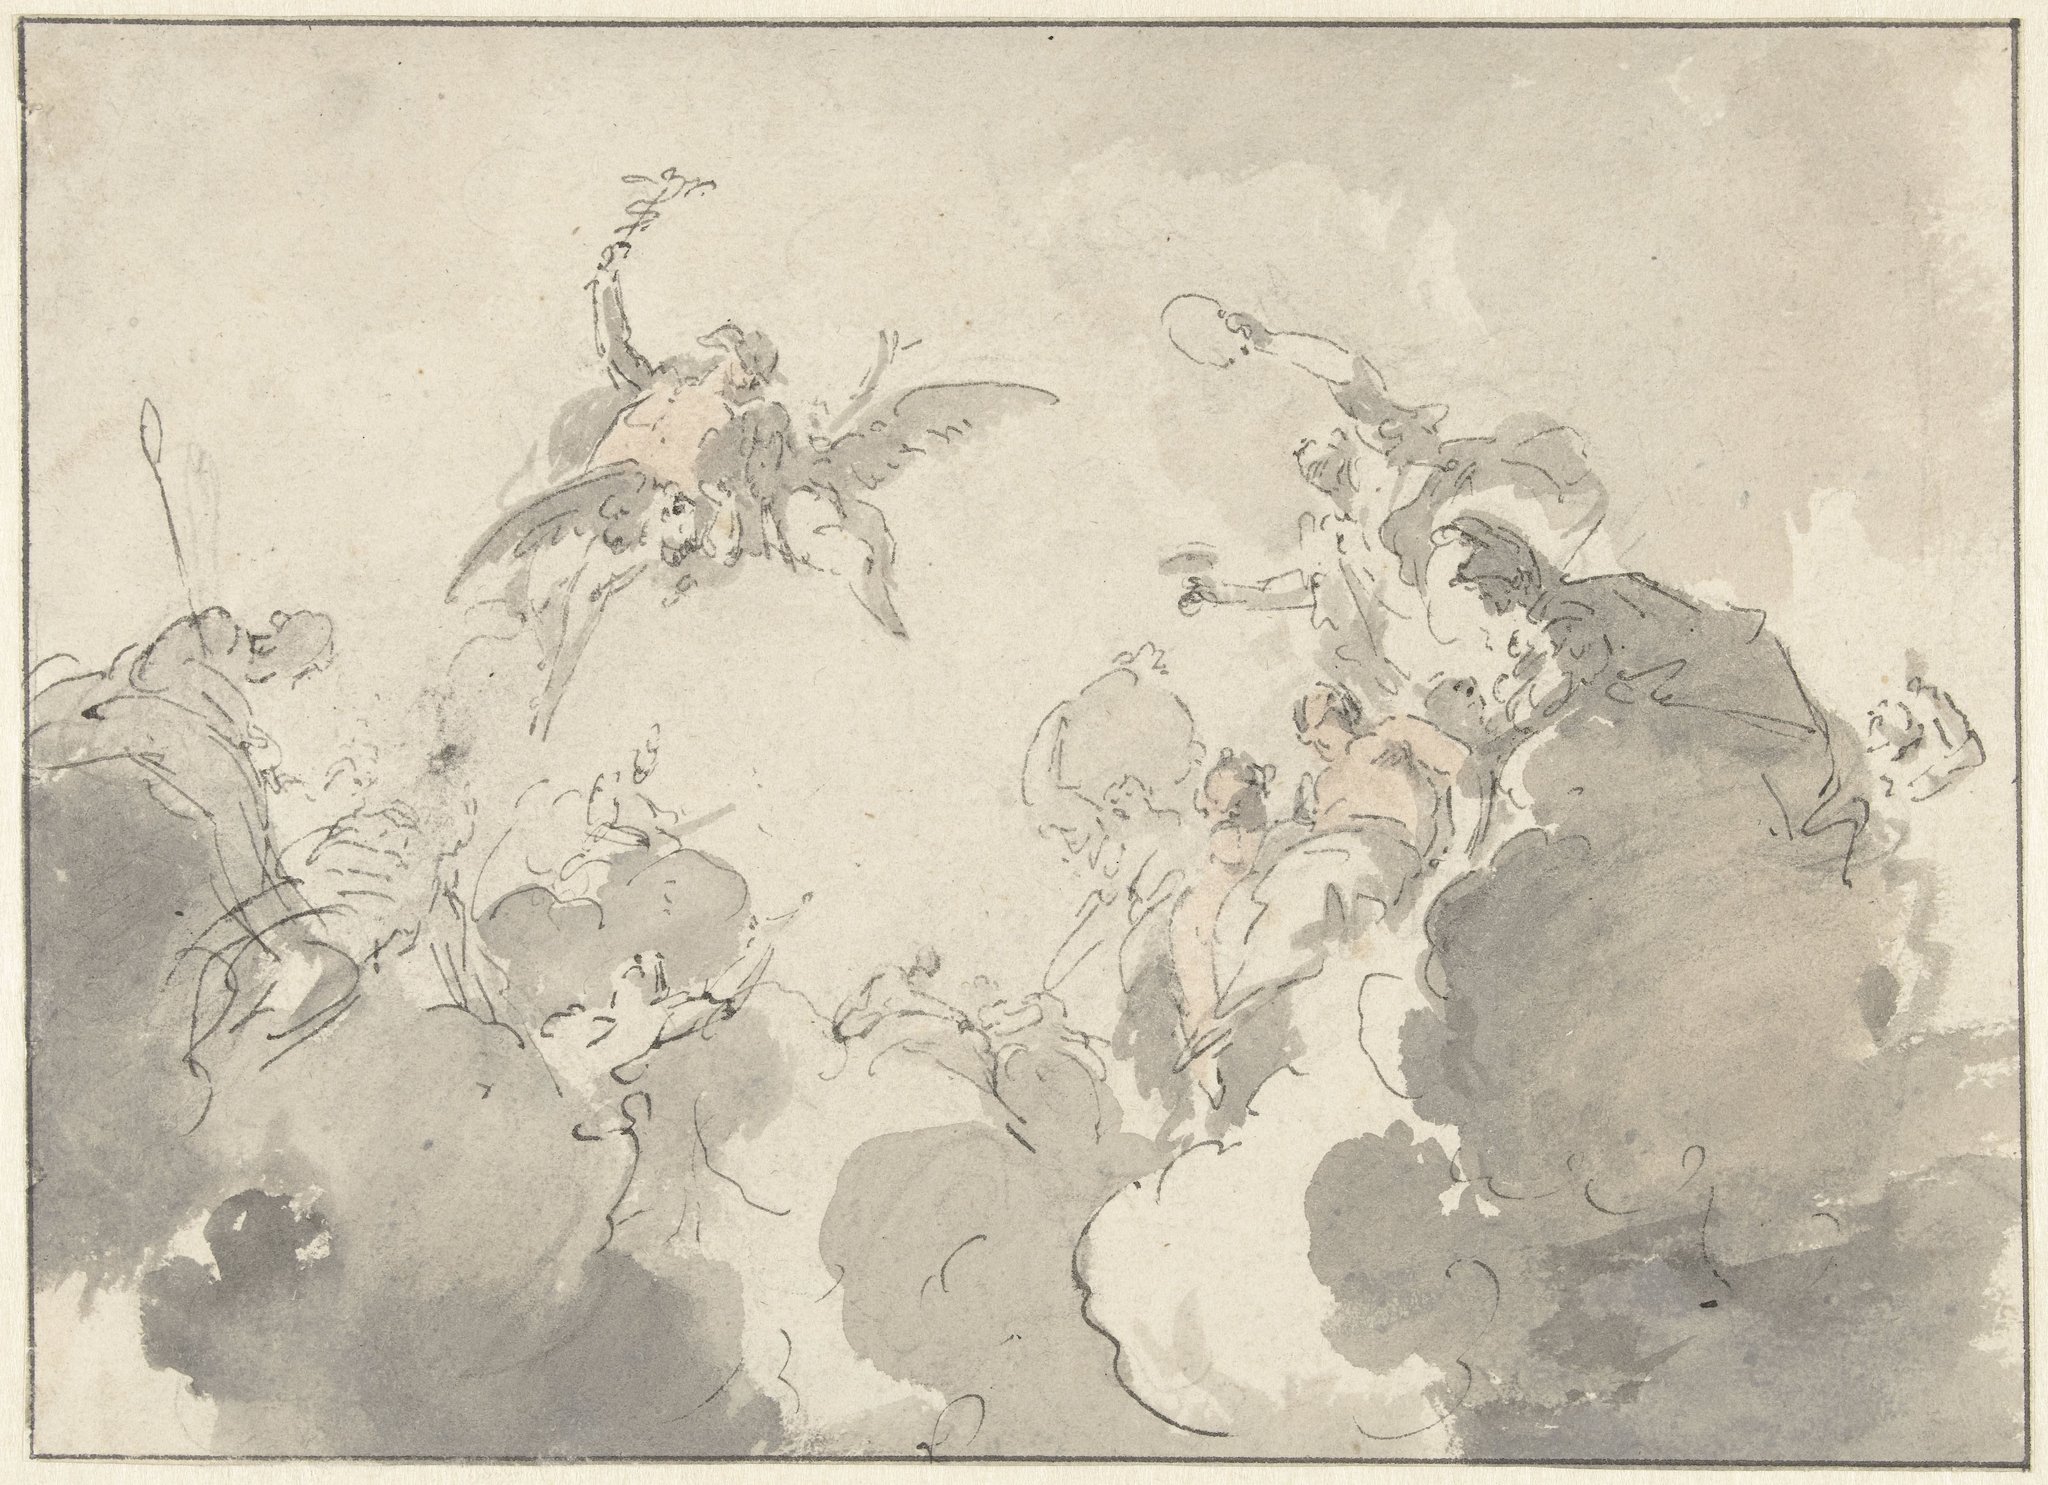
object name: drawing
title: Ontwerp voor plafondschildering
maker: jacob de wit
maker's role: draughtsman, painter, print maker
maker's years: 1695-1754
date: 1705-1754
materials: paper, pencil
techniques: brush, pen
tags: flying, sitting or standing on clouds